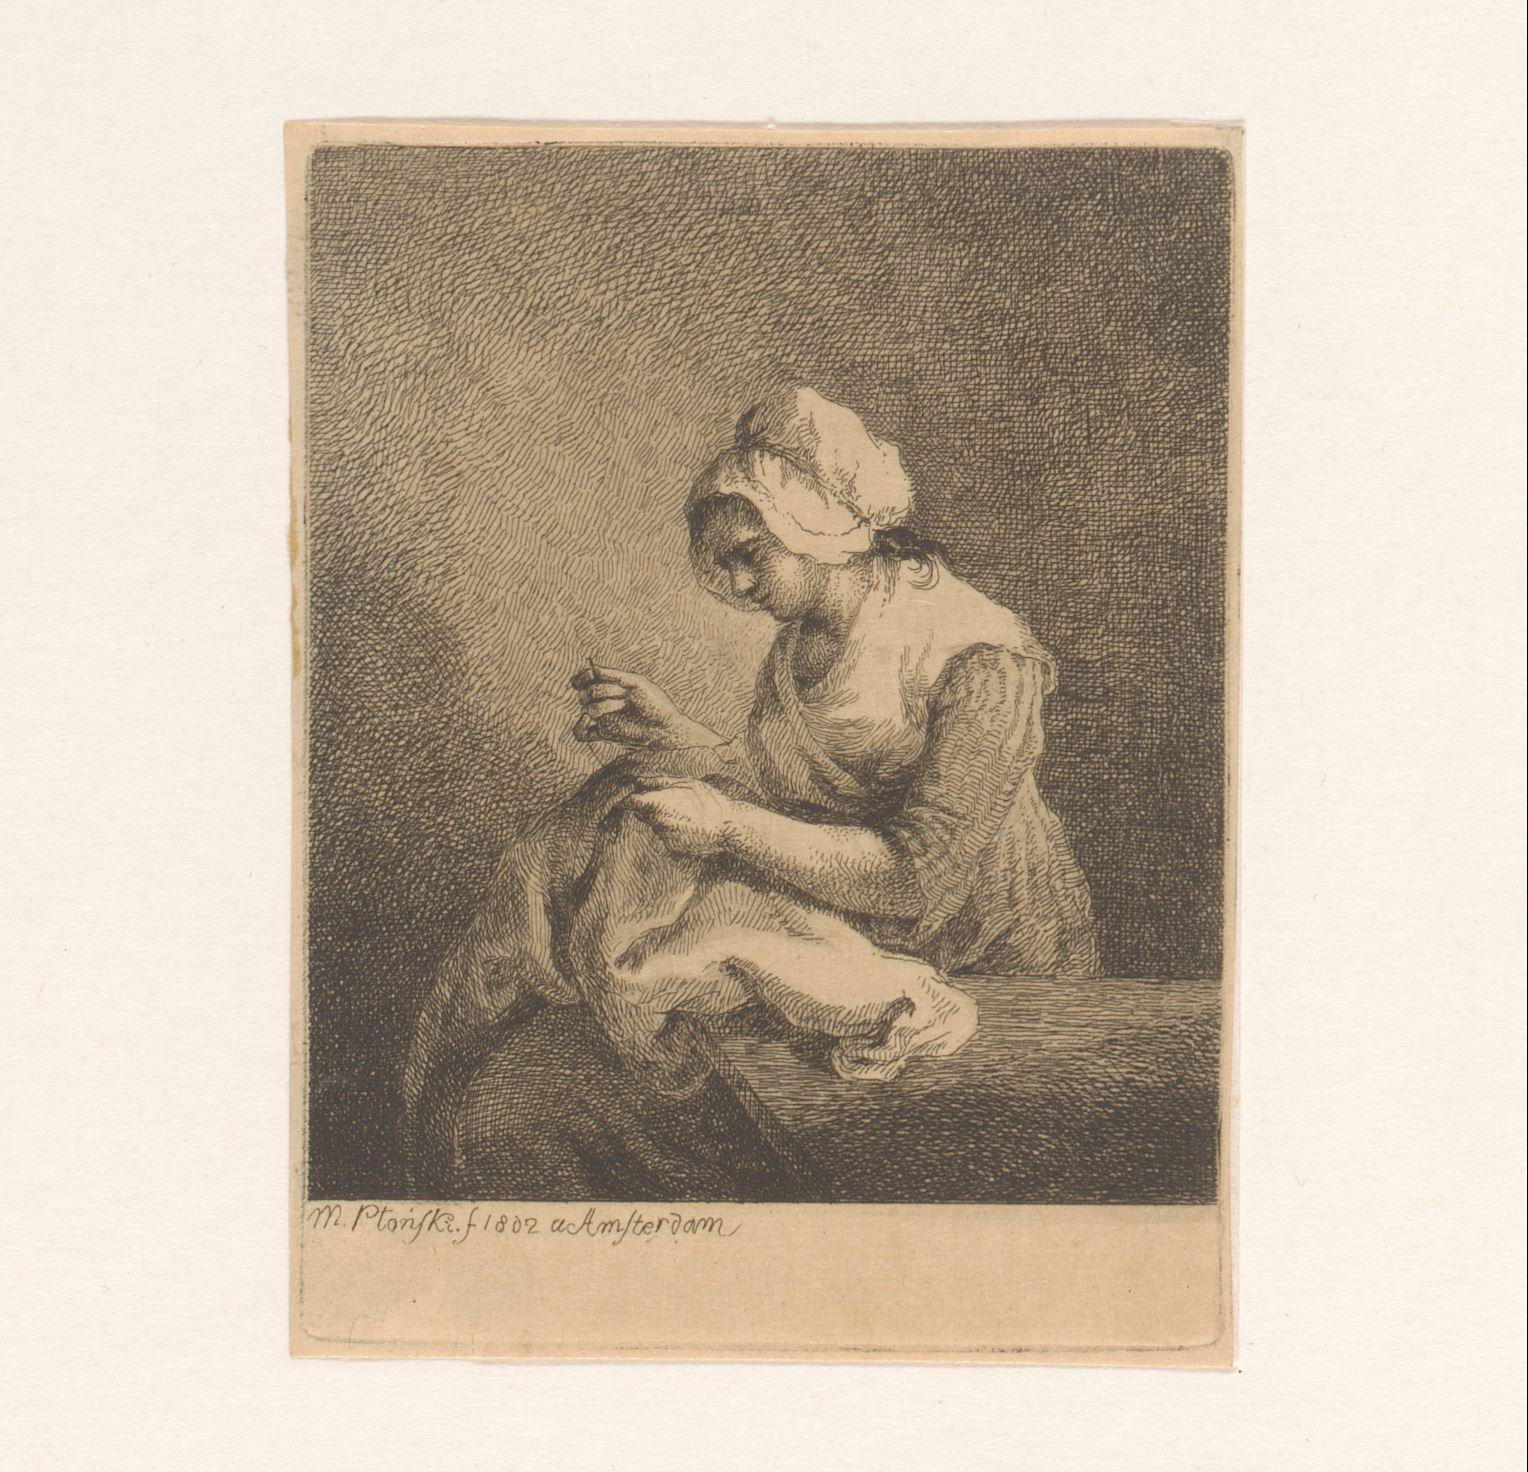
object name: print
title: Naaiende vrouw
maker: michał płoński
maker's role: print maker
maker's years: 1778-1812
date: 1802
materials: paper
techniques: etching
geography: amsterdam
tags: sewing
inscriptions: collector's mark: Lugt 2227, collector's mark: Lugt 2228